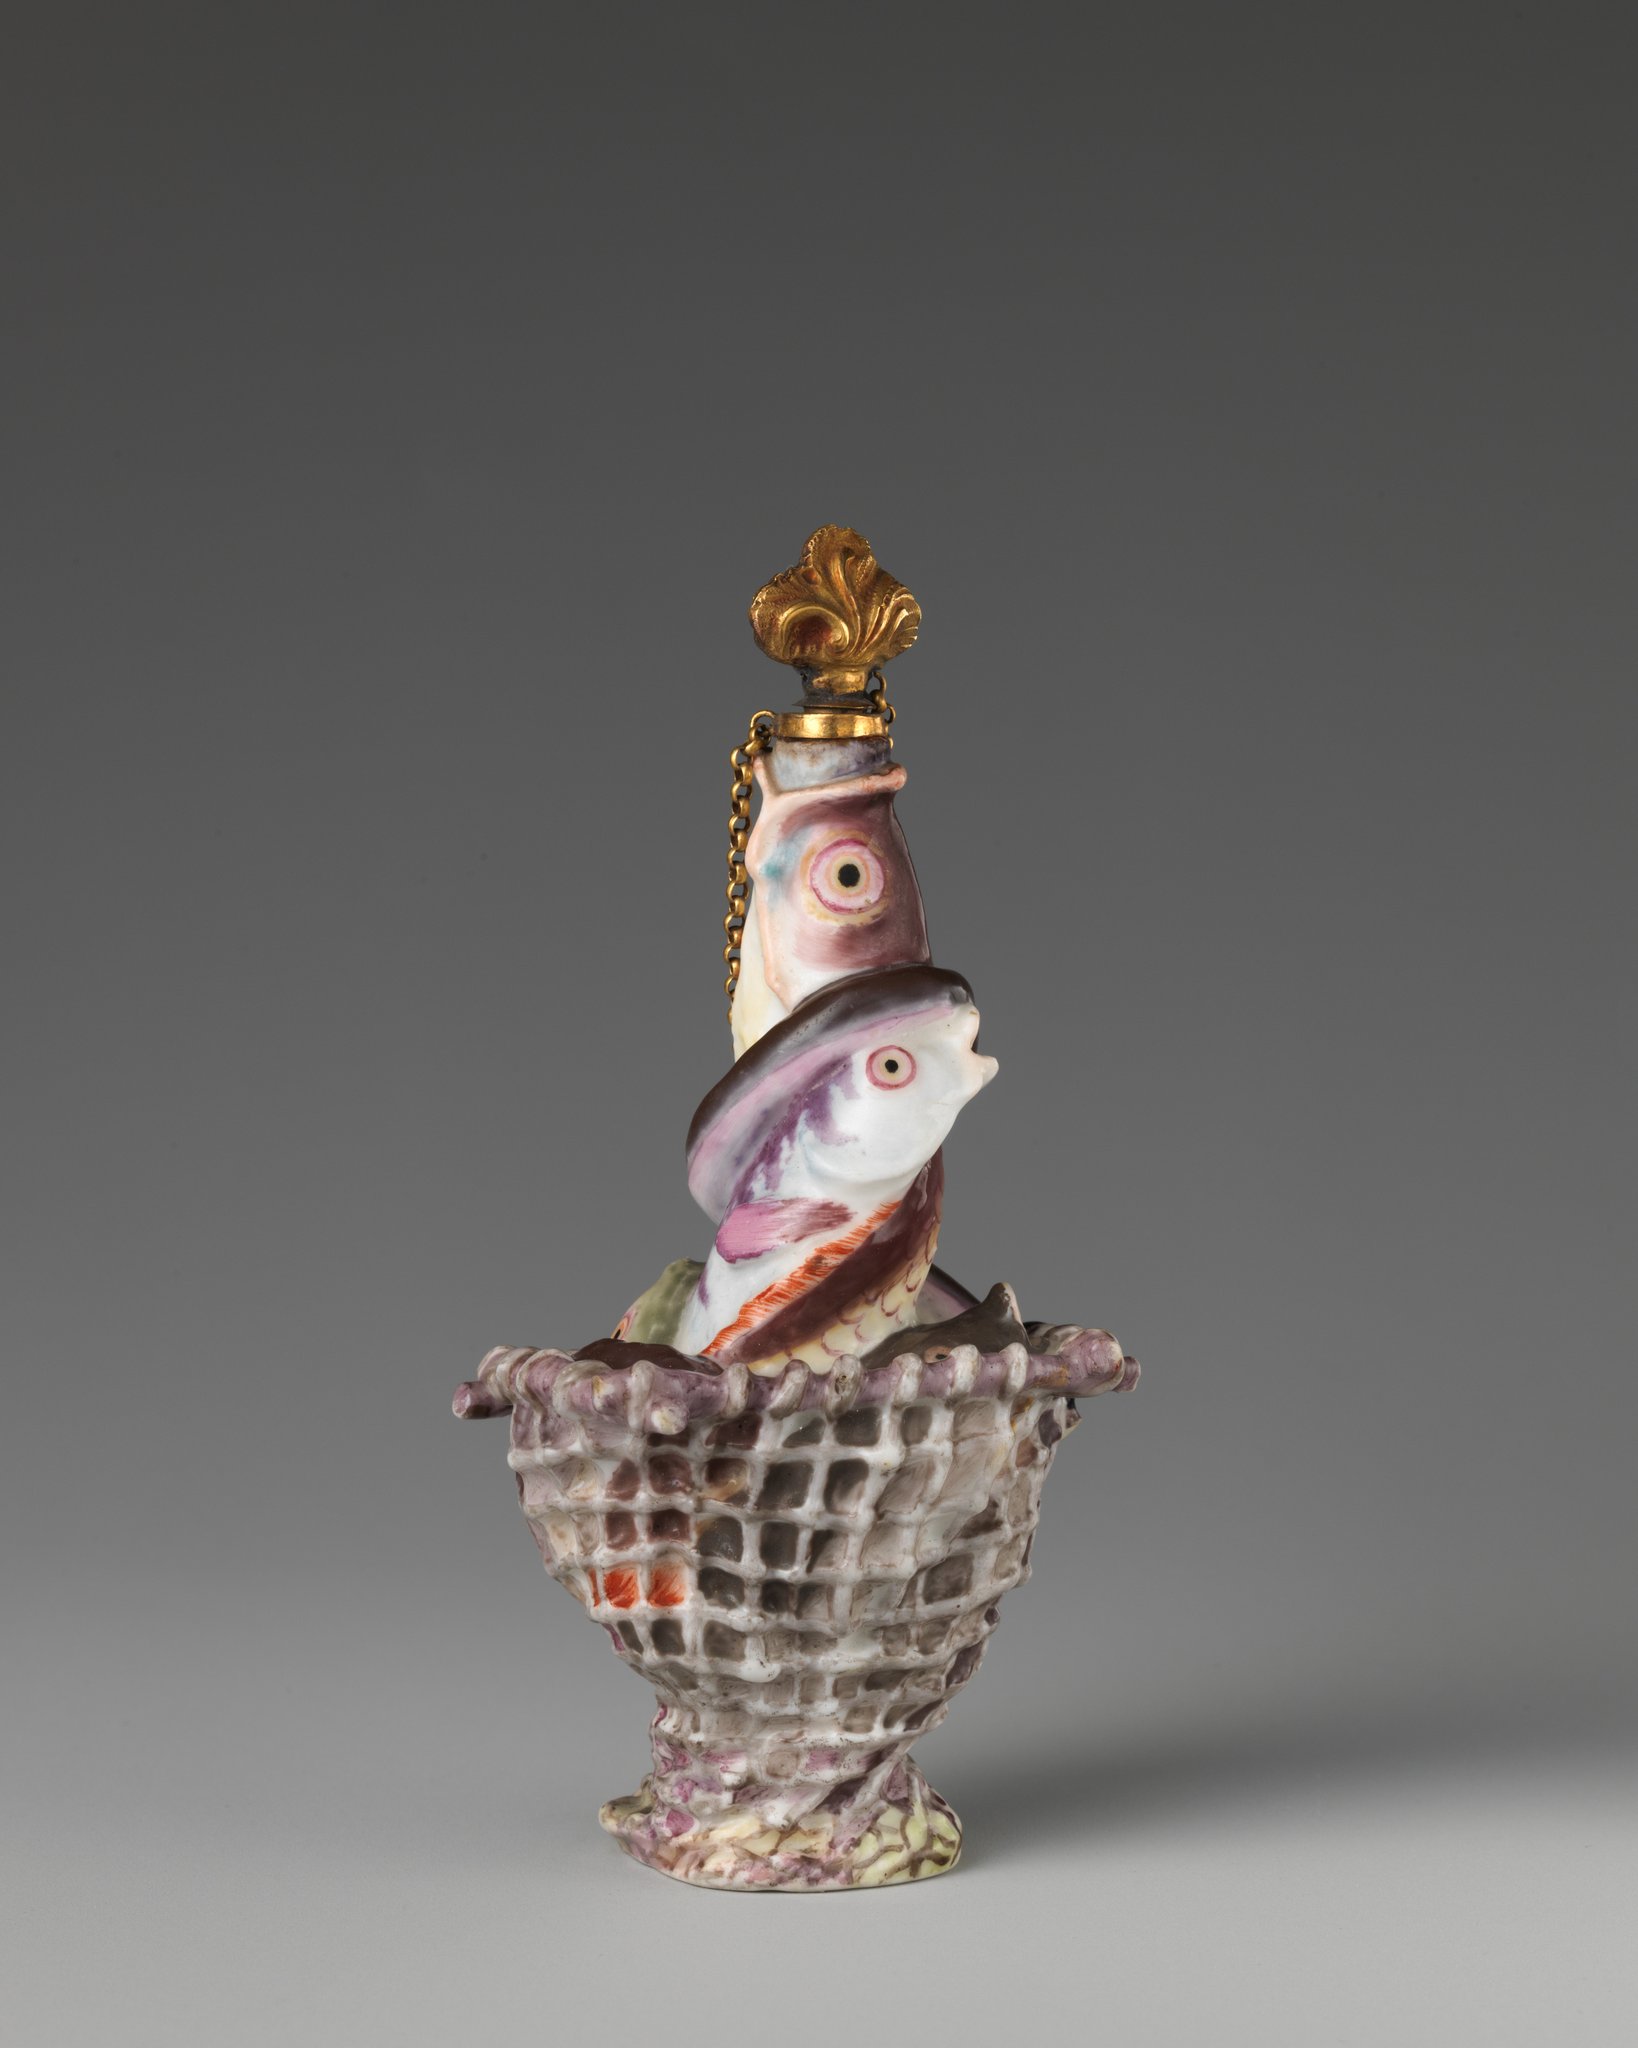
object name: toy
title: Fish in net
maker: chelsea porcelain manufactory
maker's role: factory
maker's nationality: british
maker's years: 1744-1784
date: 1755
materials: soft paste porcelain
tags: fish